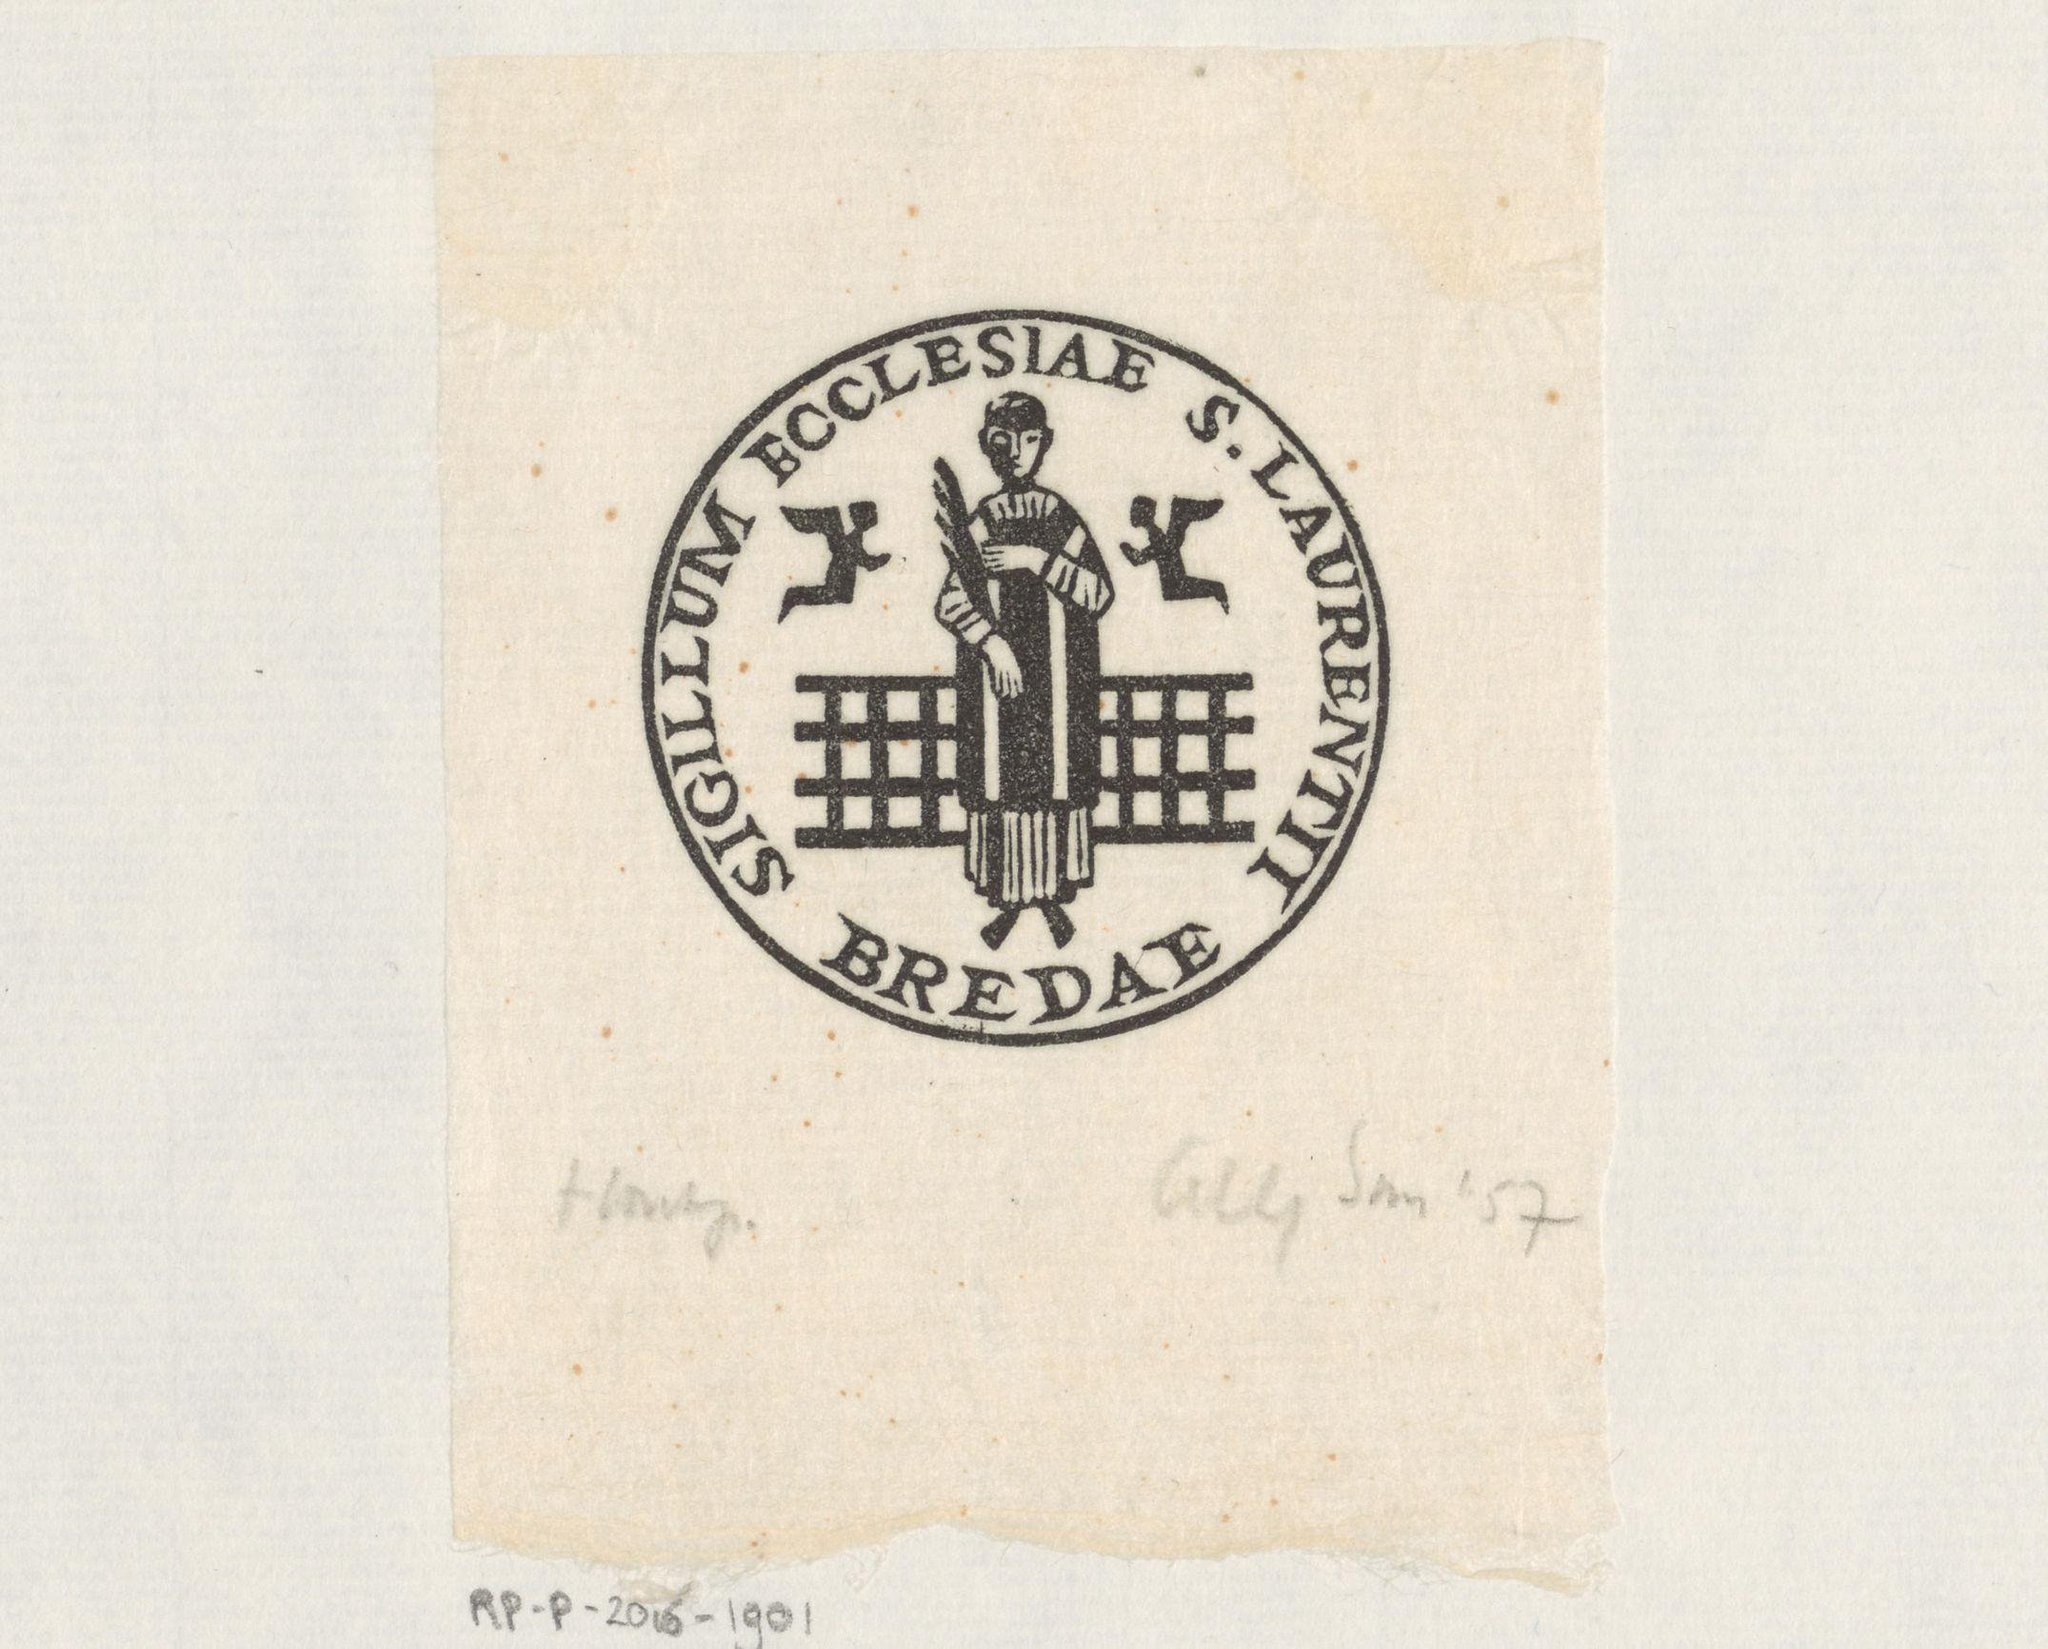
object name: bookplate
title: Ex libris van de Sint Laurentiuskerk in Breda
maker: Anonymous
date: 1957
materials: paper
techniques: engraving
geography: breda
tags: the martyr and deacon laurence of rome; possible attributes: book, censer, cross, dalmatic, gridiron, palm, purse (or cup with golden coins)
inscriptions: signature, date and inscription: ‘Houtg. / Ally Sm (?) '57’